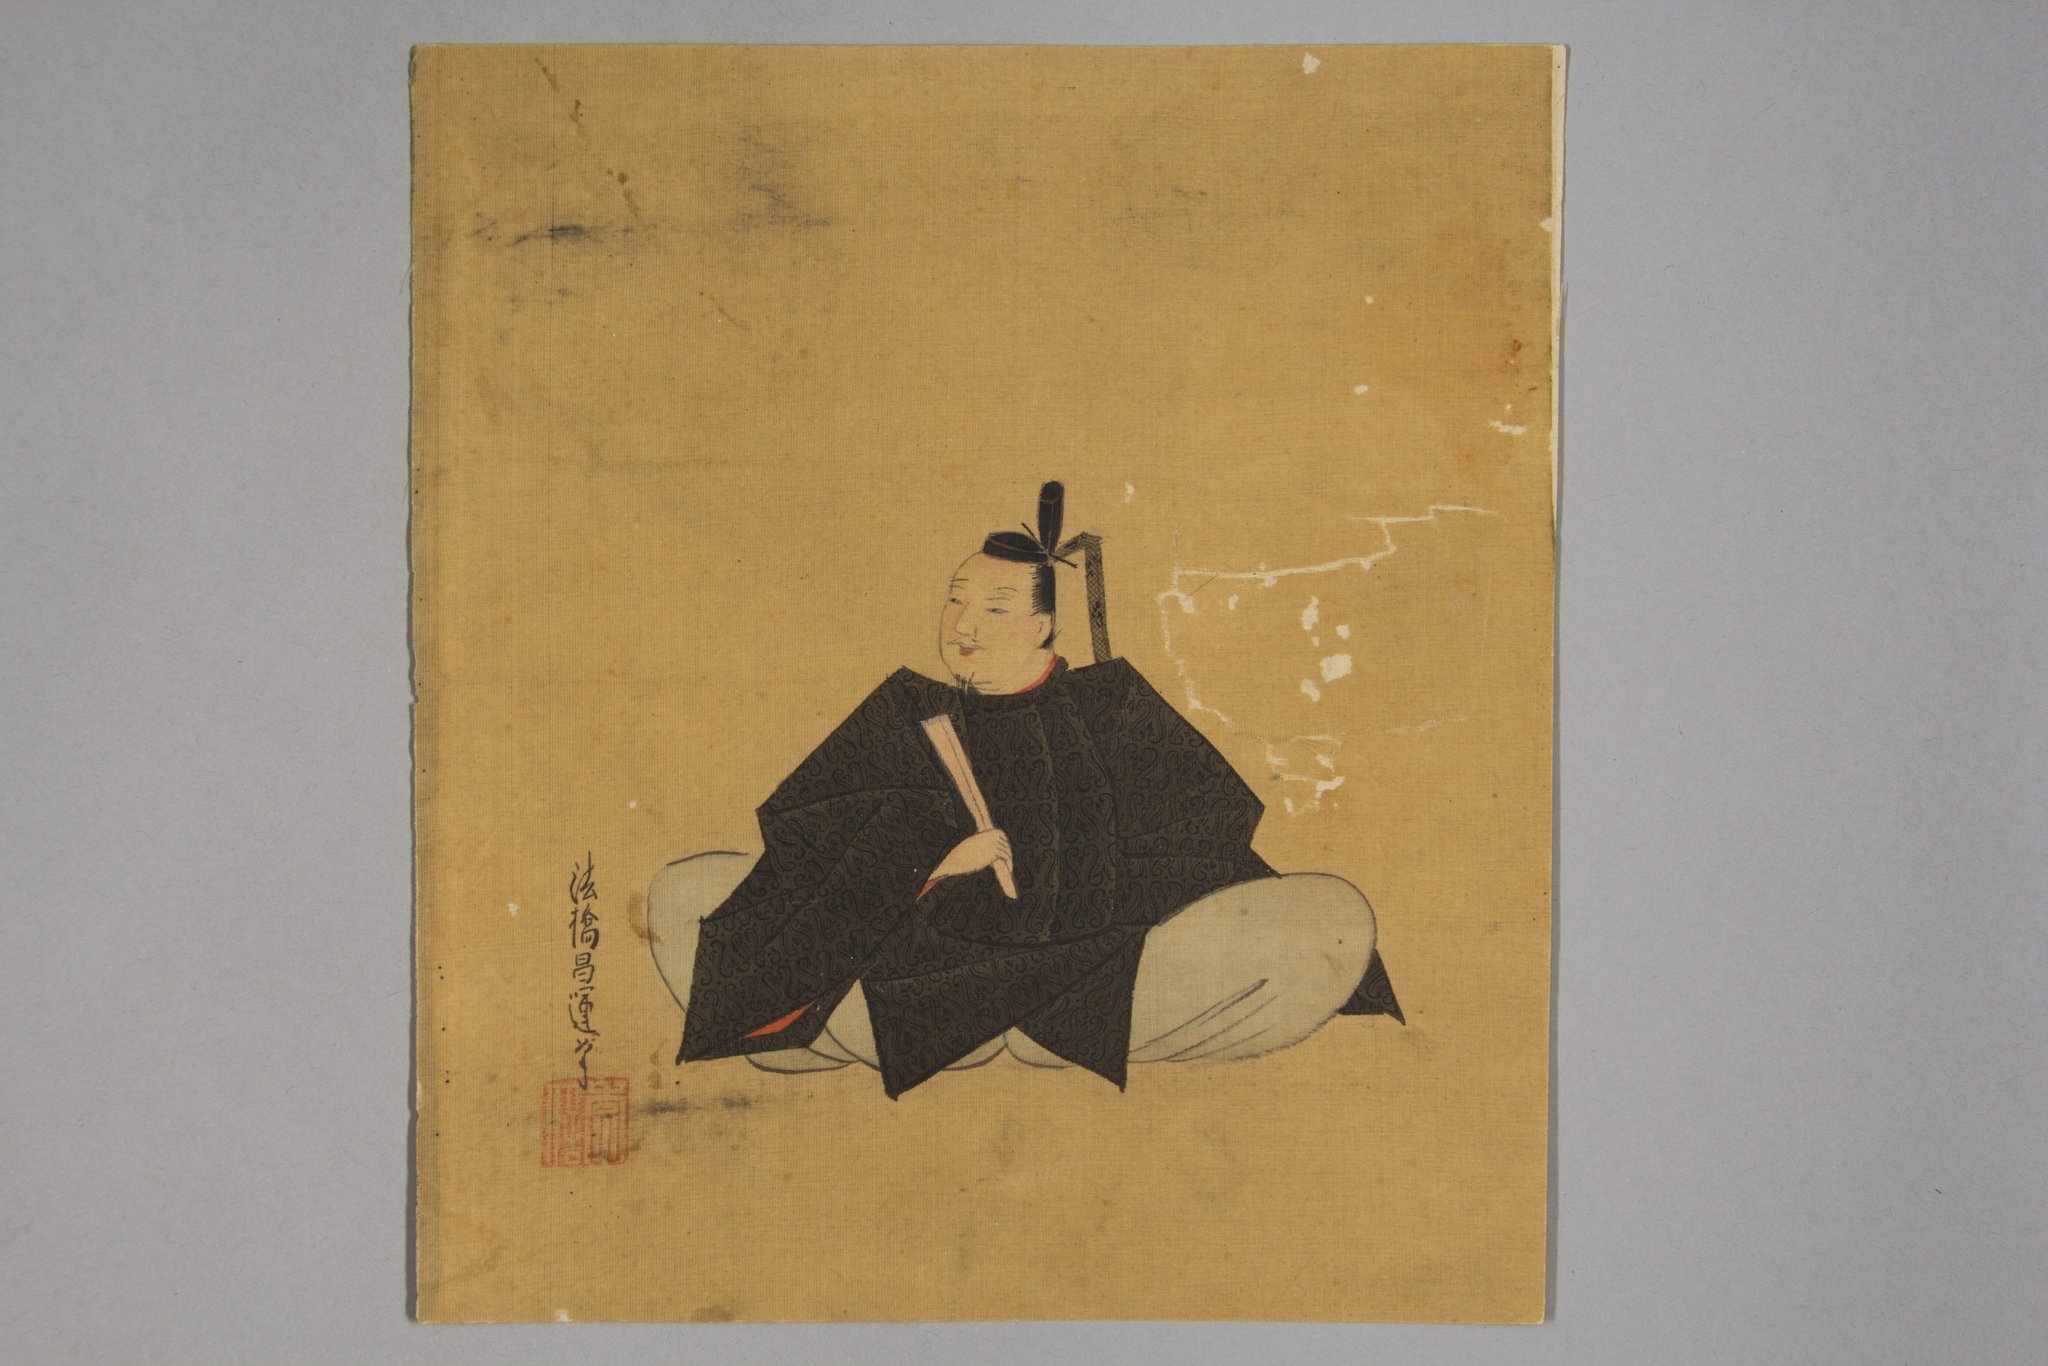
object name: painting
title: Immortal Poet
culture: japanese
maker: kano shōun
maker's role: artist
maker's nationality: japanese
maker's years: 1637-1702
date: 1601-1700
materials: ink, silk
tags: men,poets